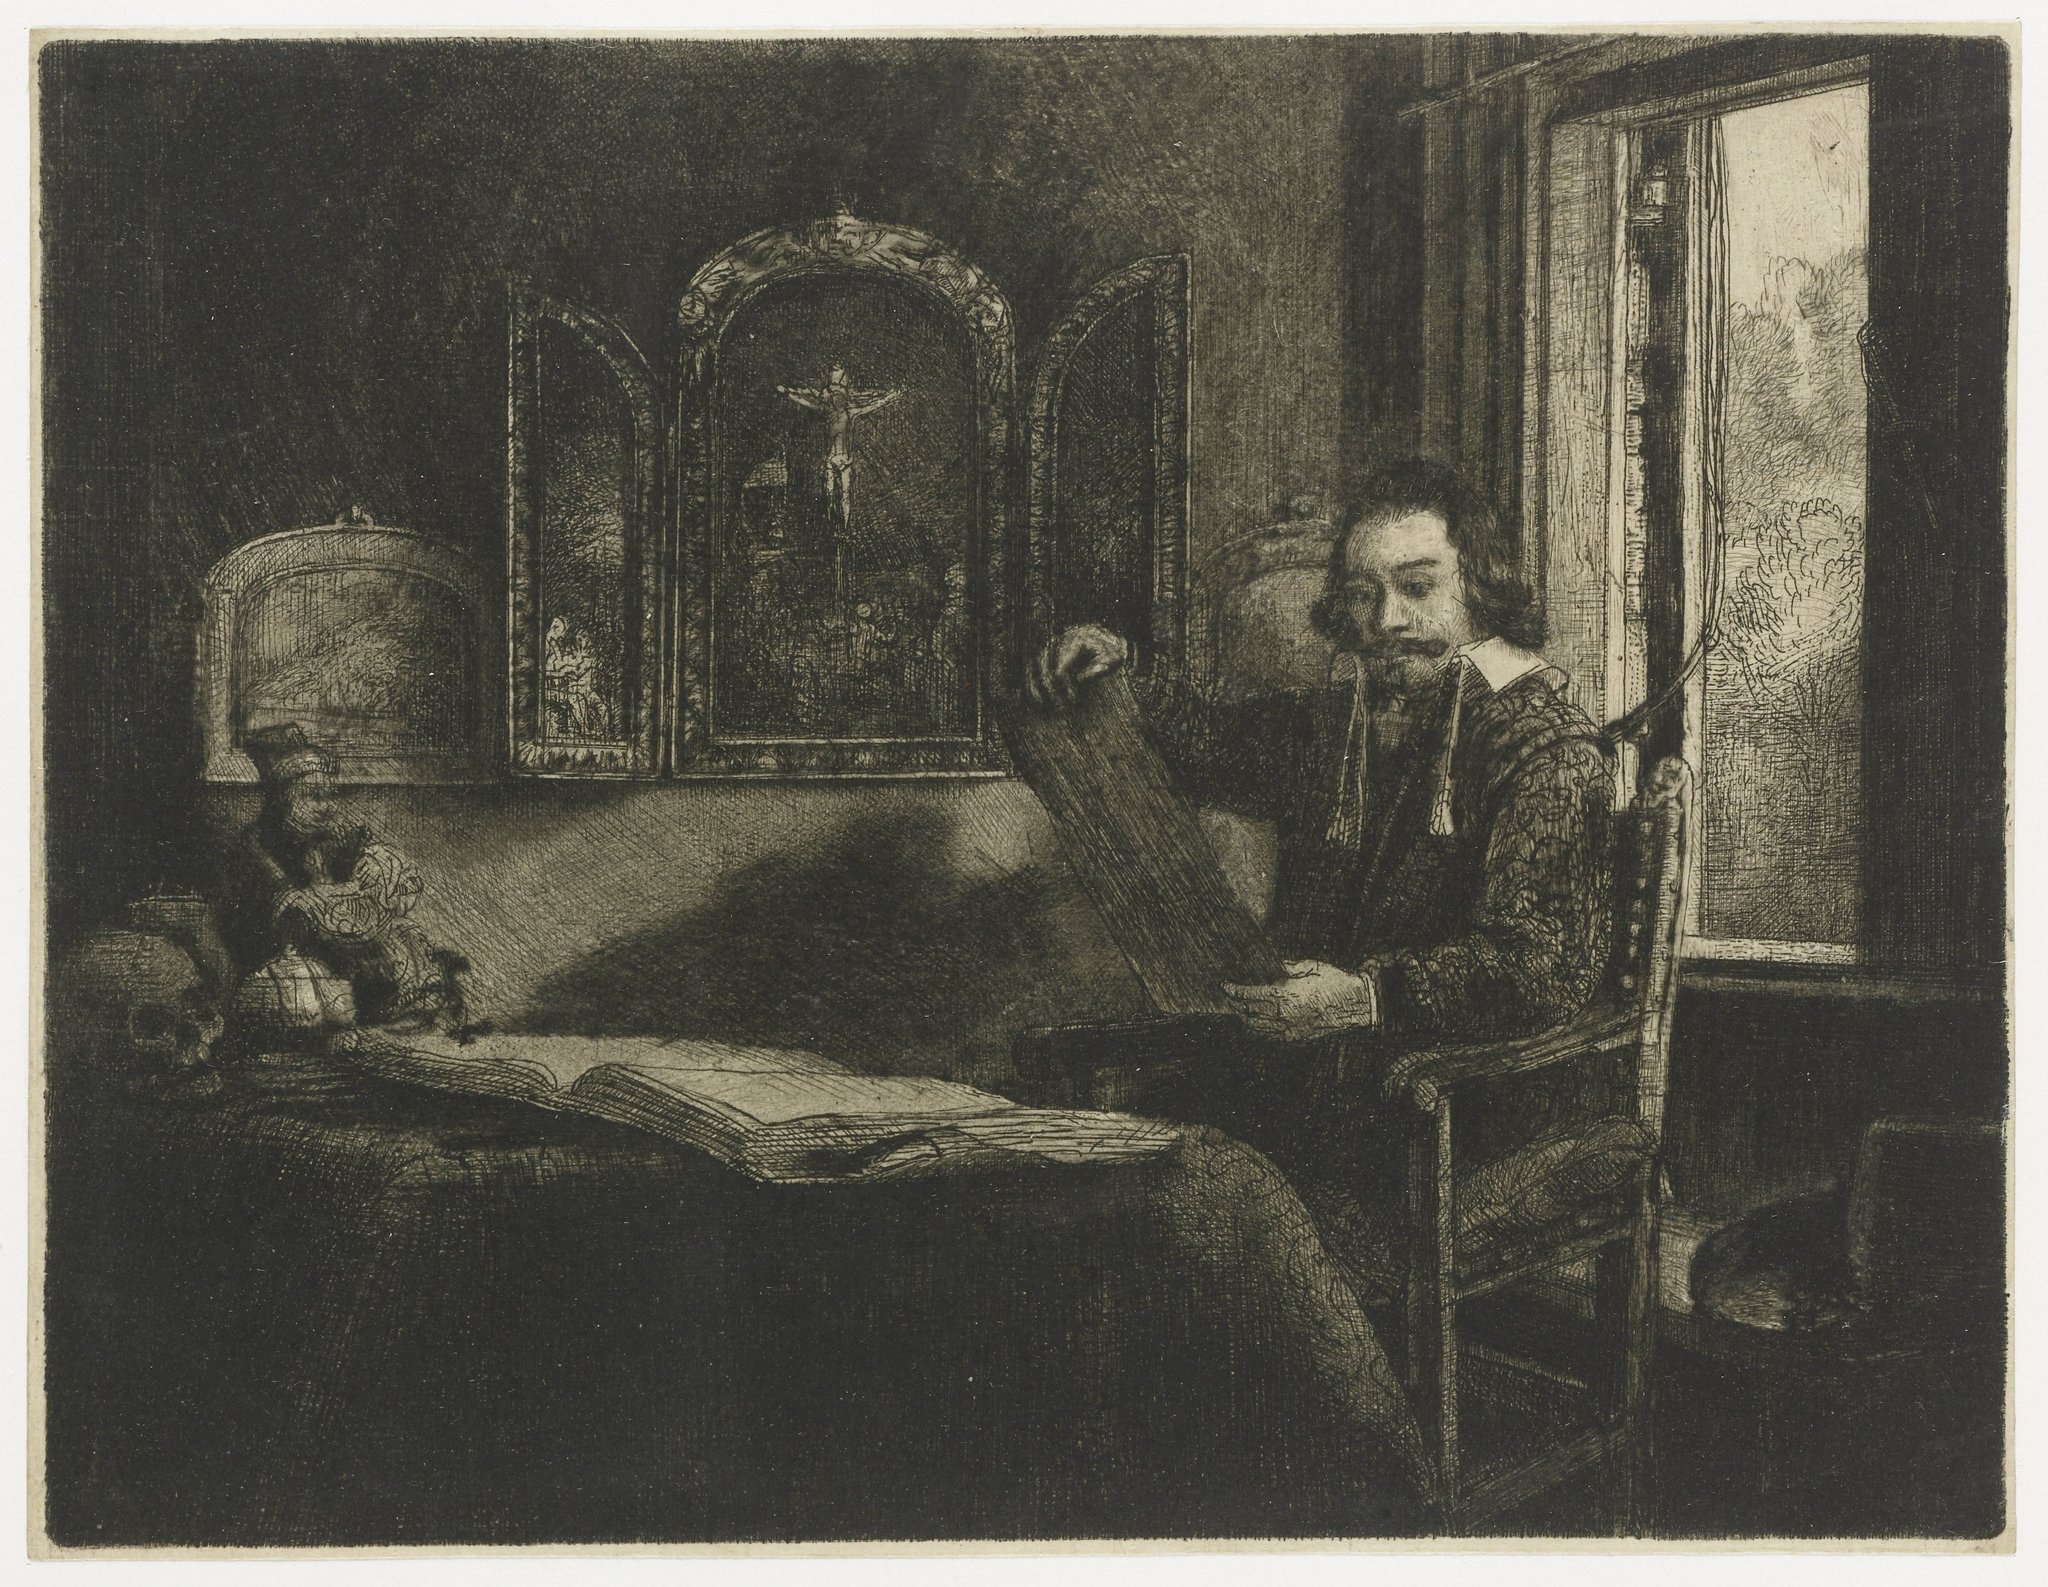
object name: print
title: Abraham Francen, apothecary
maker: rembrandt van rijn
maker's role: draughtsman, painter, print maker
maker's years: 1606-1669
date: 1657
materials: paper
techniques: drypoint, etching, intaglio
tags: kunstverzamelaar, apotheker, abraham francen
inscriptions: mark: Lugt 2228, mark: Lugt 151